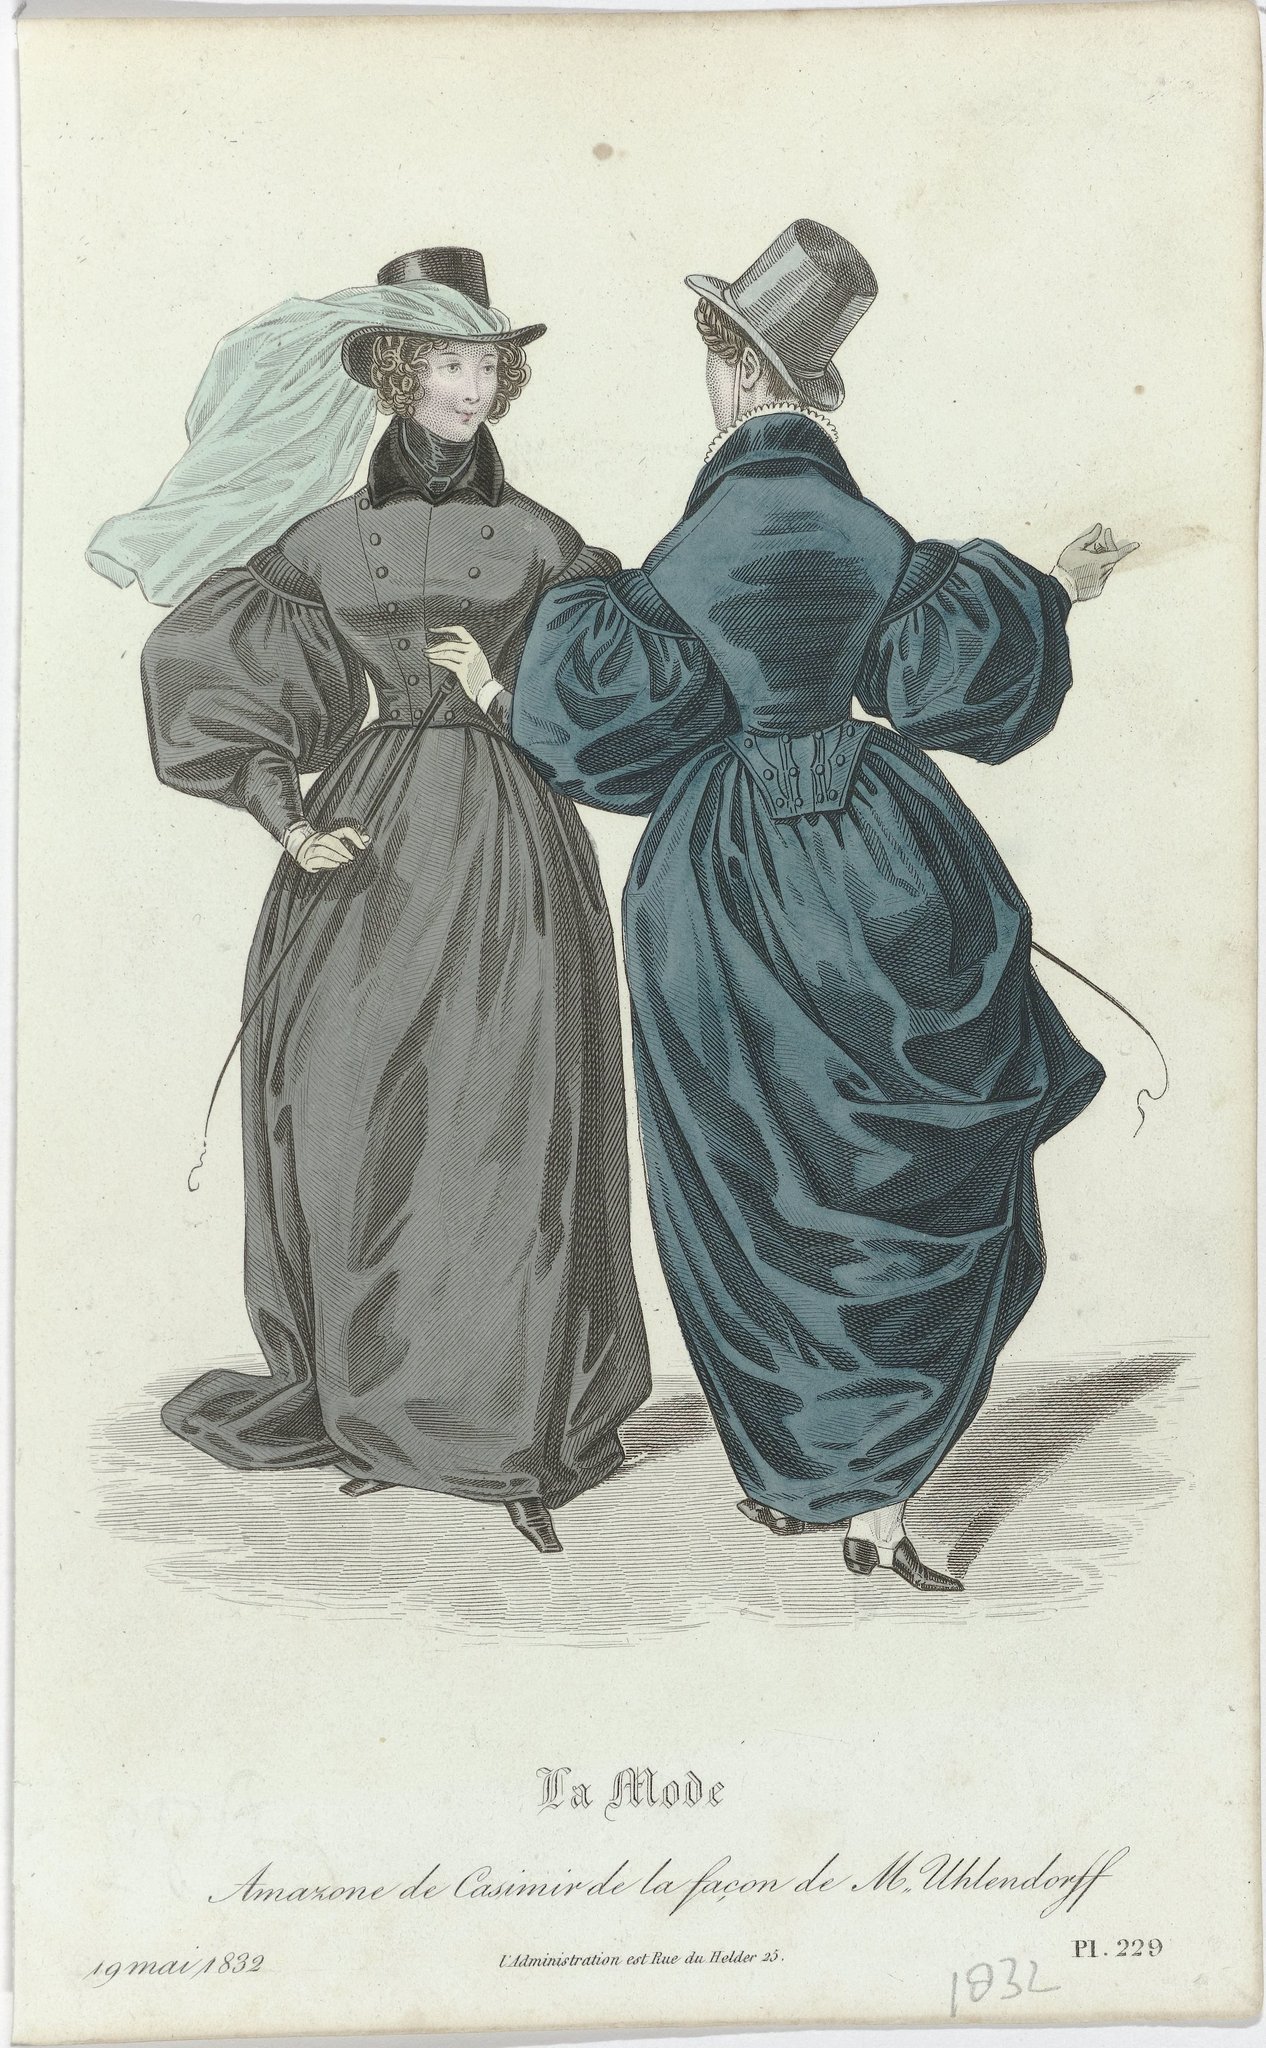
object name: fashion print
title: La Mode, 19 mai 1832, Pl. 229 : Amazone de Casimir (...)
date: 1832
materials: paper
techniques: hand coloring, engraving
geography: paris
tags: riding a horse, ass, or mule; rider, horseman (+ variant), veil (+ women's clothes), trousers, breeches (+ women's clothes), underclothes for the lower part of the body: bloomers (+ women's clothes), head-gear (+ women's clothes), fashion plates, shoes, sandals (+ women's clothes), gloves, mittens, etc. (+ women's clothes), dress, gown (+ women's clothes), neck-gear ~ clothing (+ women's clothes), whip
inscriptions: address: ‘L'Administration est Rue du Helder 25.’, title: ‘La Mode.’, caption: ‘Amazone de Casimir de la façon de M'Uhlendorff’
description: Amazonekostuuum (rijkostuum) van 'casimir', volgens het model van M Uhlendorff. Jas met schapenboutmouwen. Rok met sleep, waaronder bloomers of spanbroek. Accessoires: hoge hoed met sluier, handschoenen, zweep, schoenen met vierkante neuzen en hakken. Prent uit het modetijdschrift La Mode (1829-1855).